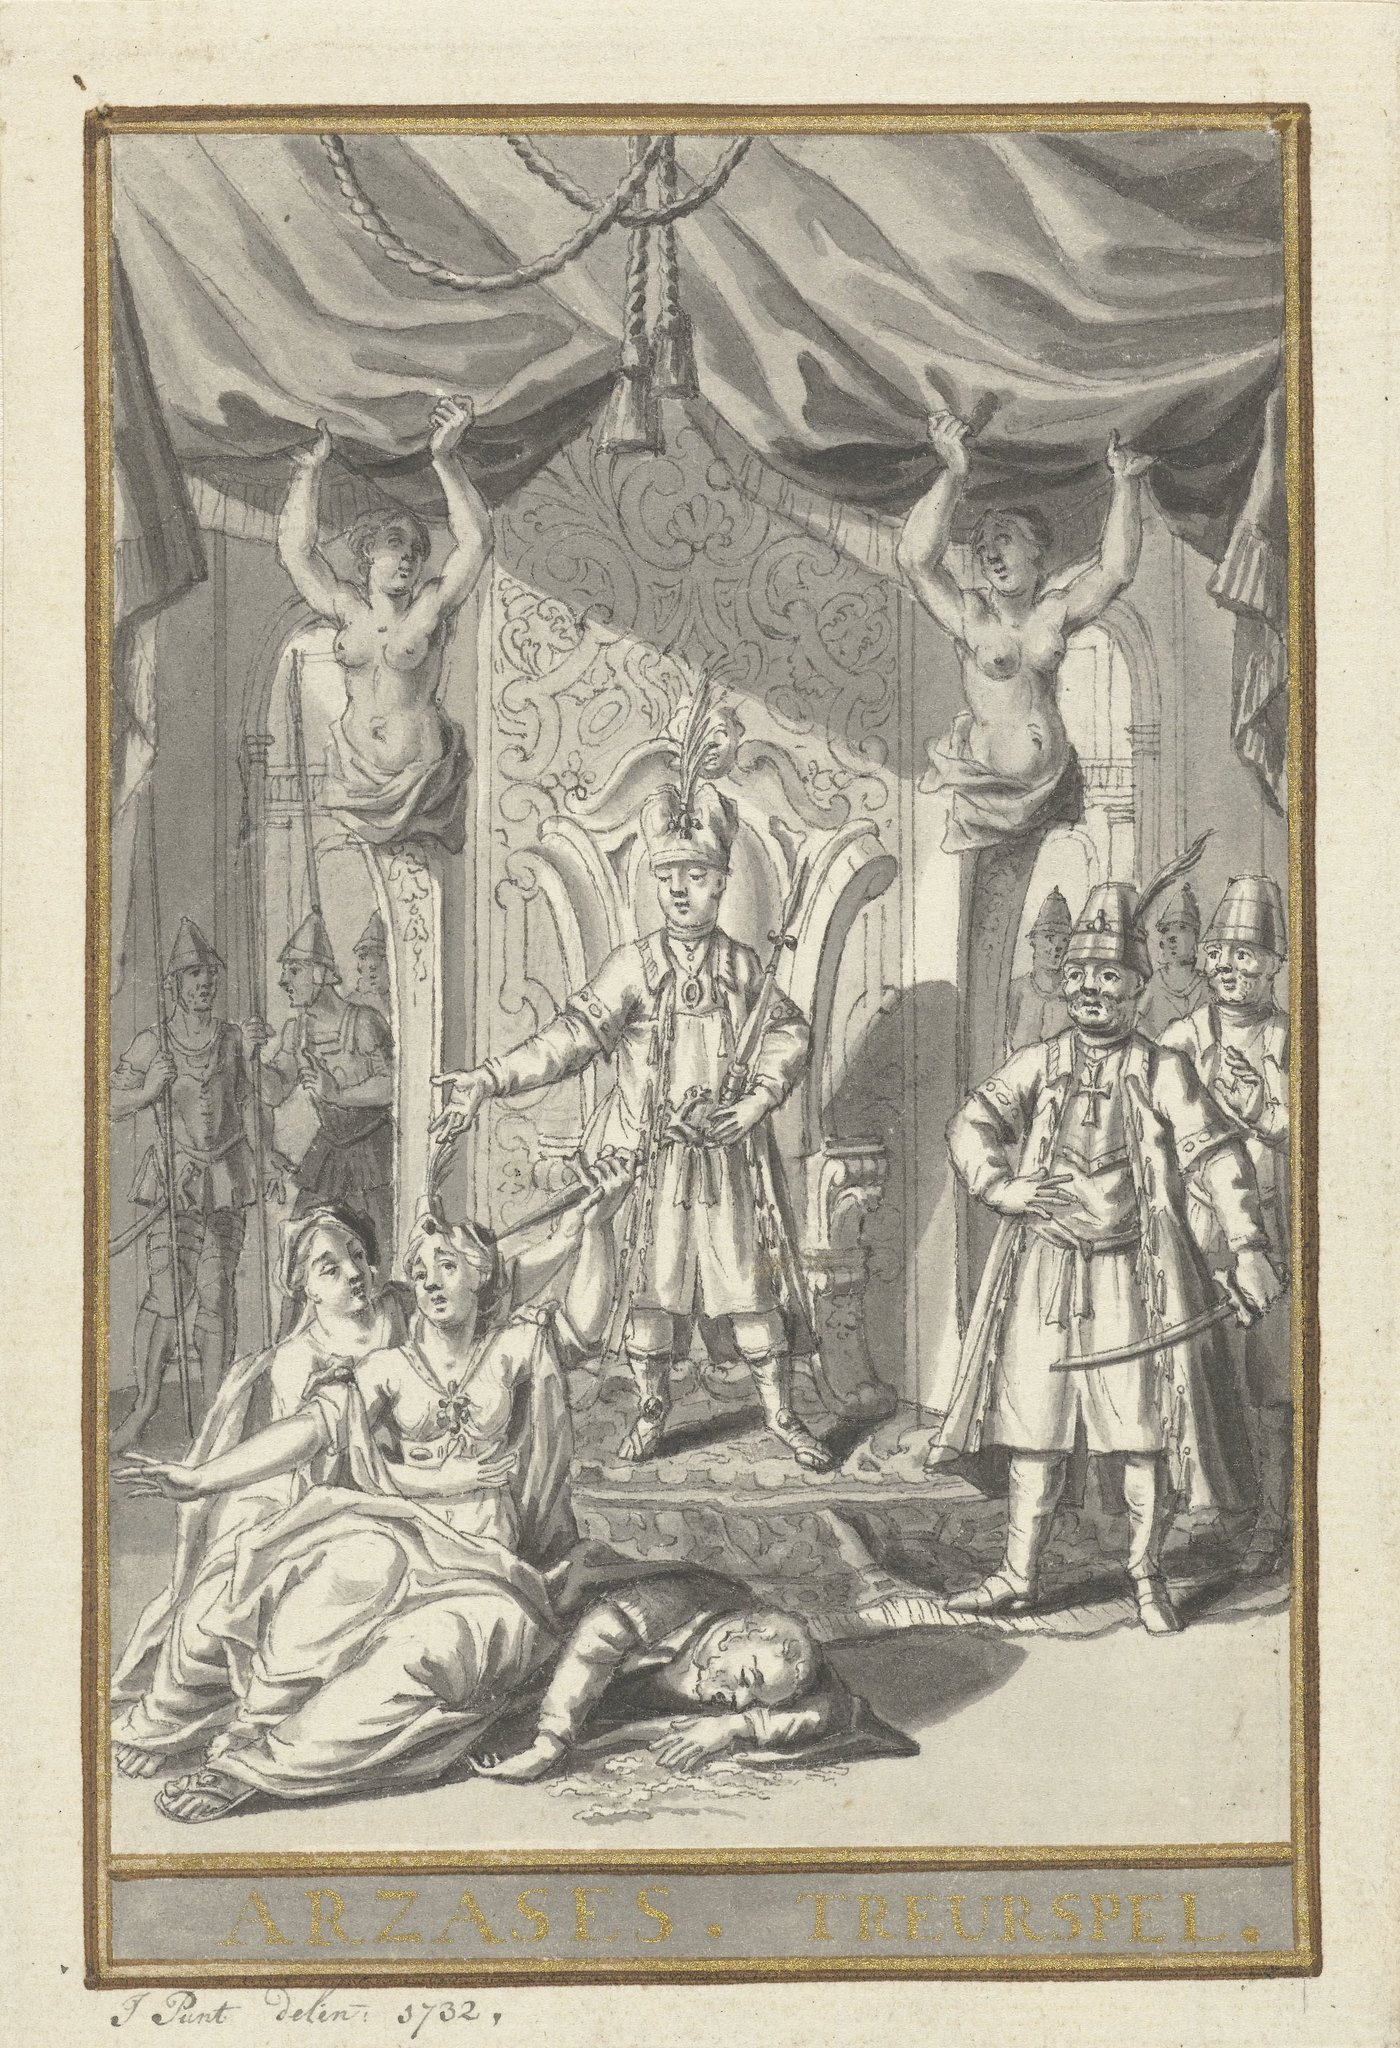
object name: drawing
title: Ontwerp voor het titelblad van het treurspel Arzases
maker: jan punt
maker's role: draughtsman, print maker, publisher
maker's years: 1711-1779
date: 1732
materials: chalk, paint, ink, paper, pencil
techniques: brush, pen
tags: (scenes from) specific works of literature (with author, title), group of actors, troupe; actors on the stage